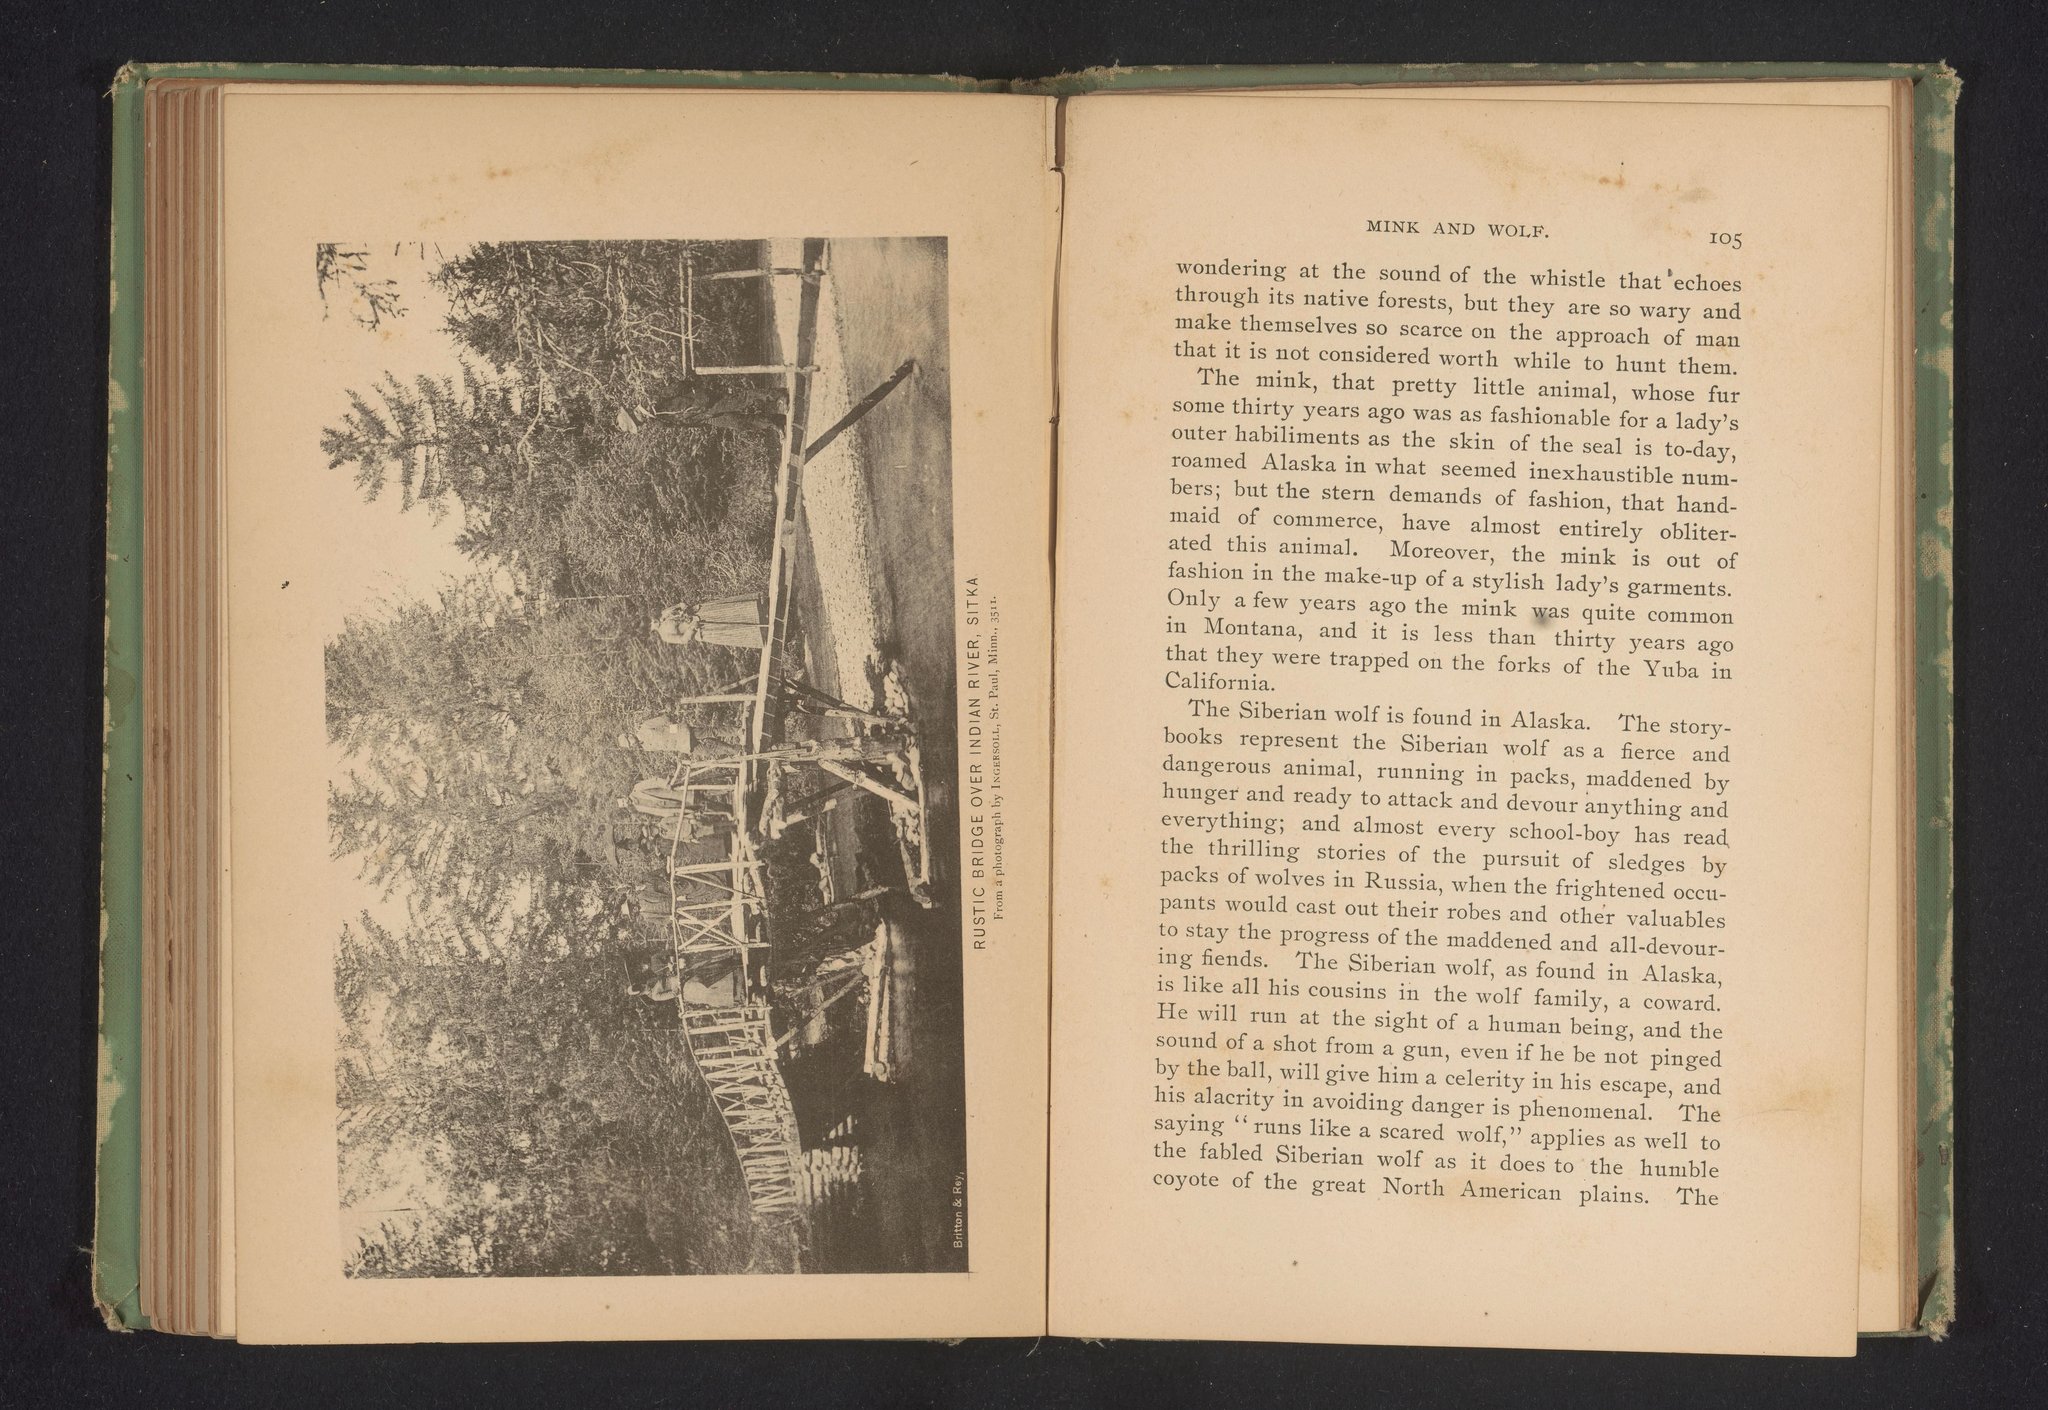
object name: page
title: Groepsportret van een gezelschap op een brug in Sitka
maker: truman ward ingersoll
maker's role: fotograaf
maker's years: 1862-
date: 1885-1890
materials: paper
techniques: photograph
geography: sitka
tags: river, anonymous historical persons portrayed in a group, in a group-portrait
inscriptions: inscription: ‘From photograph by Ingersoll, St. Paul, Minn., 3511.’